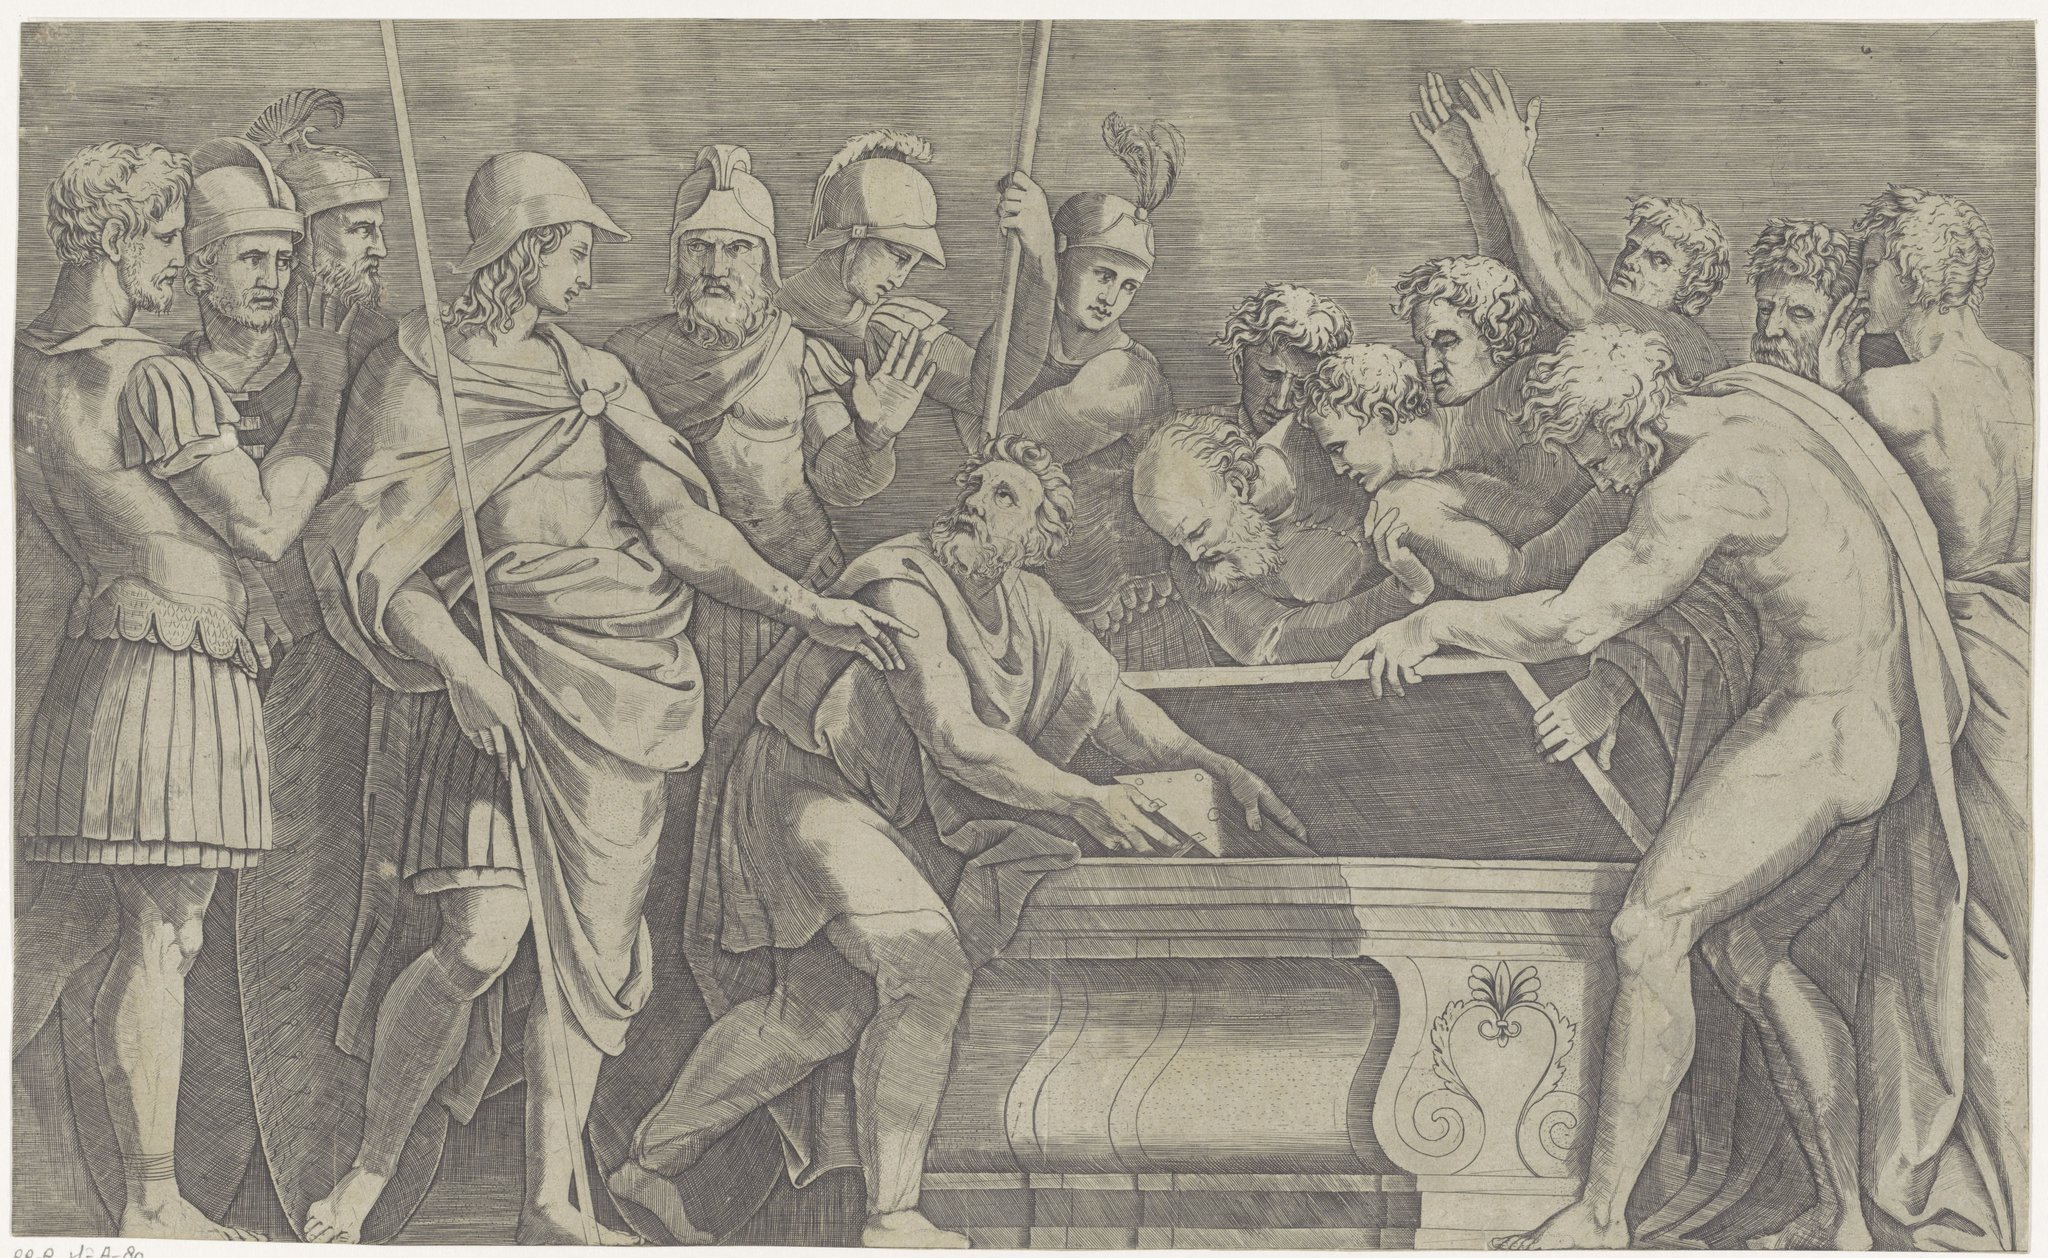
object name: print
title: Alexander de Grote laat de werken van Homerus veilig opbergen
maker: Anonymous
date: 1515-1575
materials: paper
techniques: engraving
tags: alexander has the books of homer put into a chest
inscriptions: collector's mark: Lugt 11, collector's mark: Lugt 10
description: Kopie naar prent van Marcantonio Raimondi. Raimondi baseerde zijn prent op een ontwerp van Raphael voor een grisaille in de Stanza della Segnatura, Vaticaan, Rome (tekening in collectie Ashmolean Museum, Oxford).